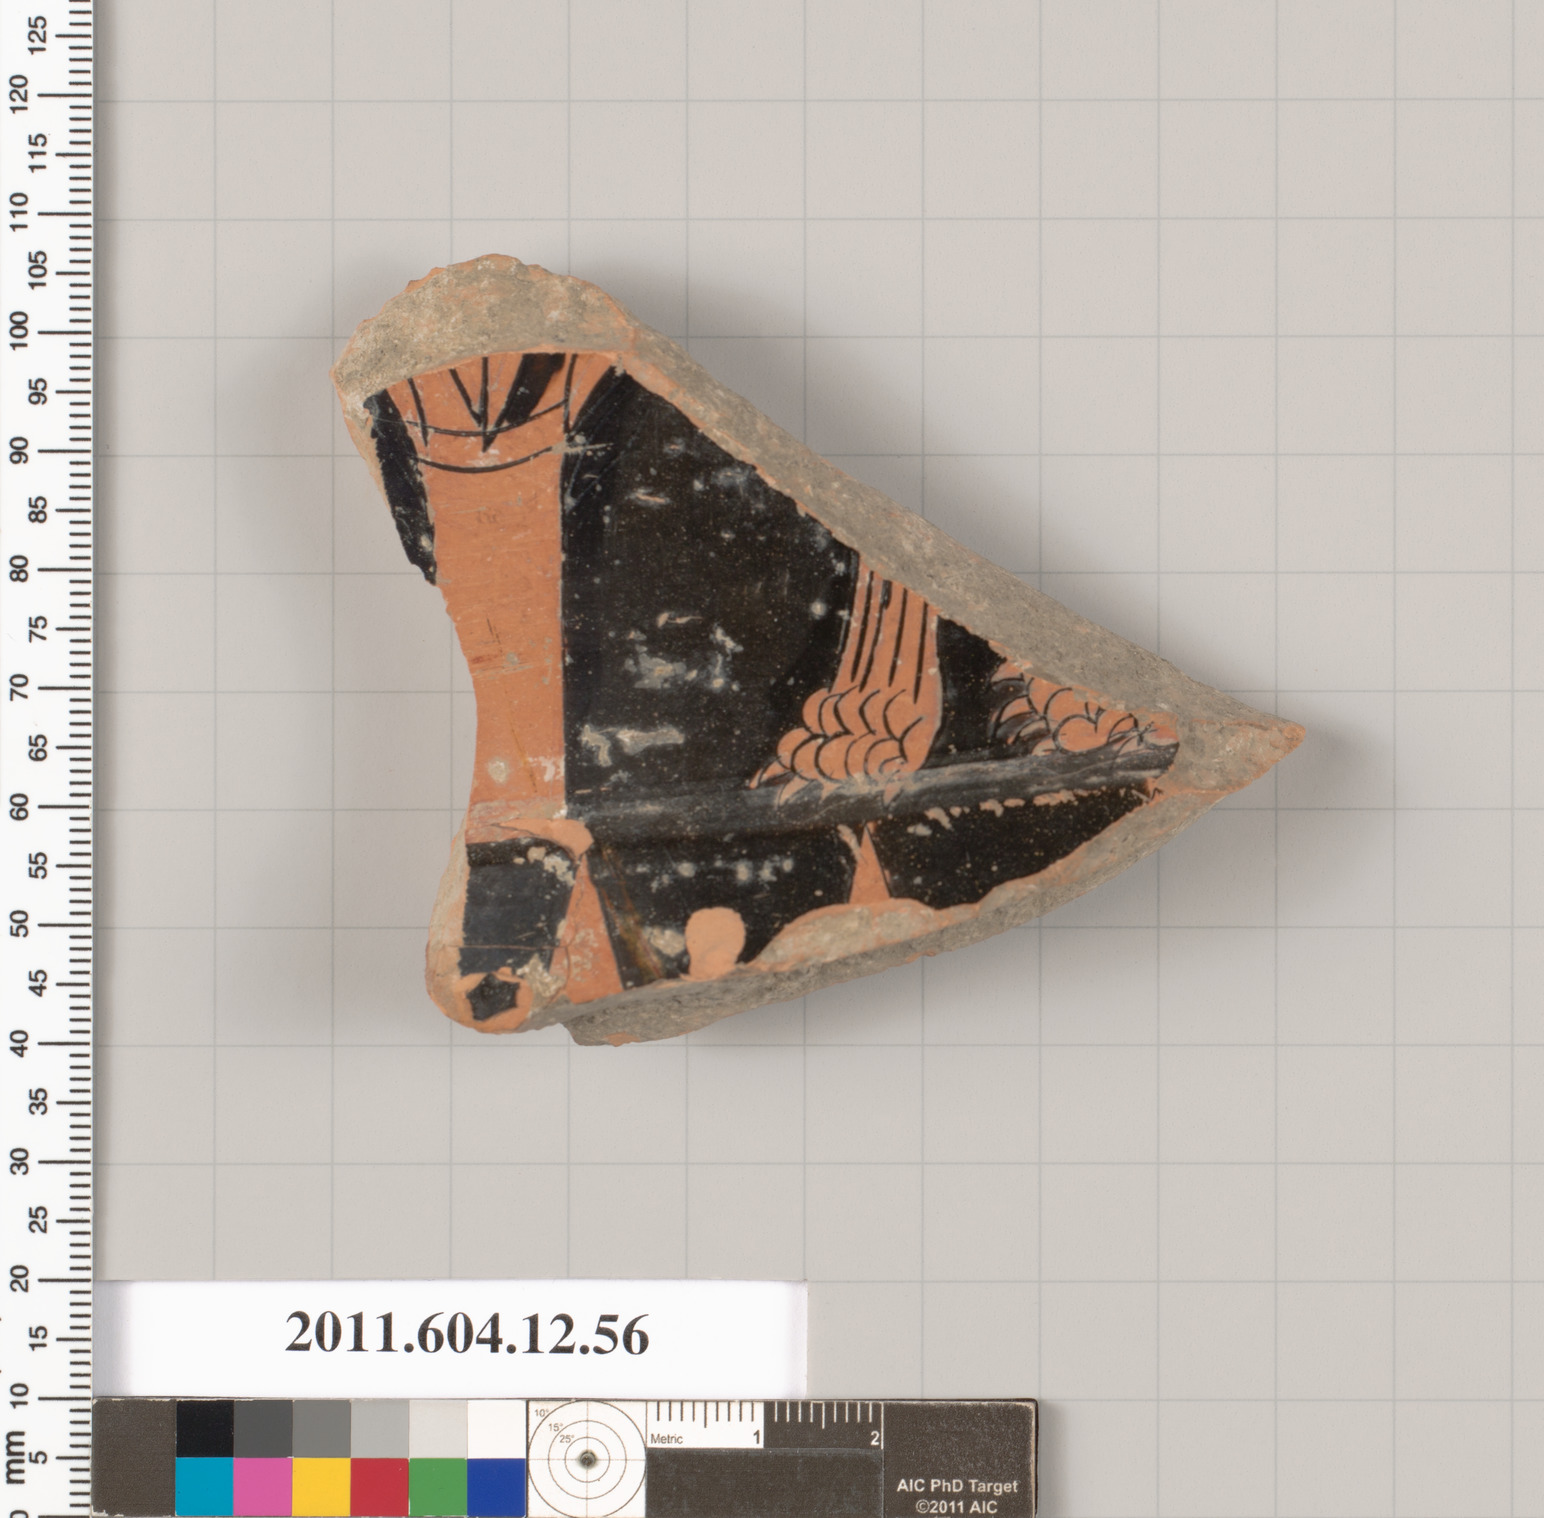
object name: volute krater fragment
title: Terracotta fragment of a volute-krater (deep bowl)?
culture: greek or south italian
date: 400-301 BCE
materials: terracotta